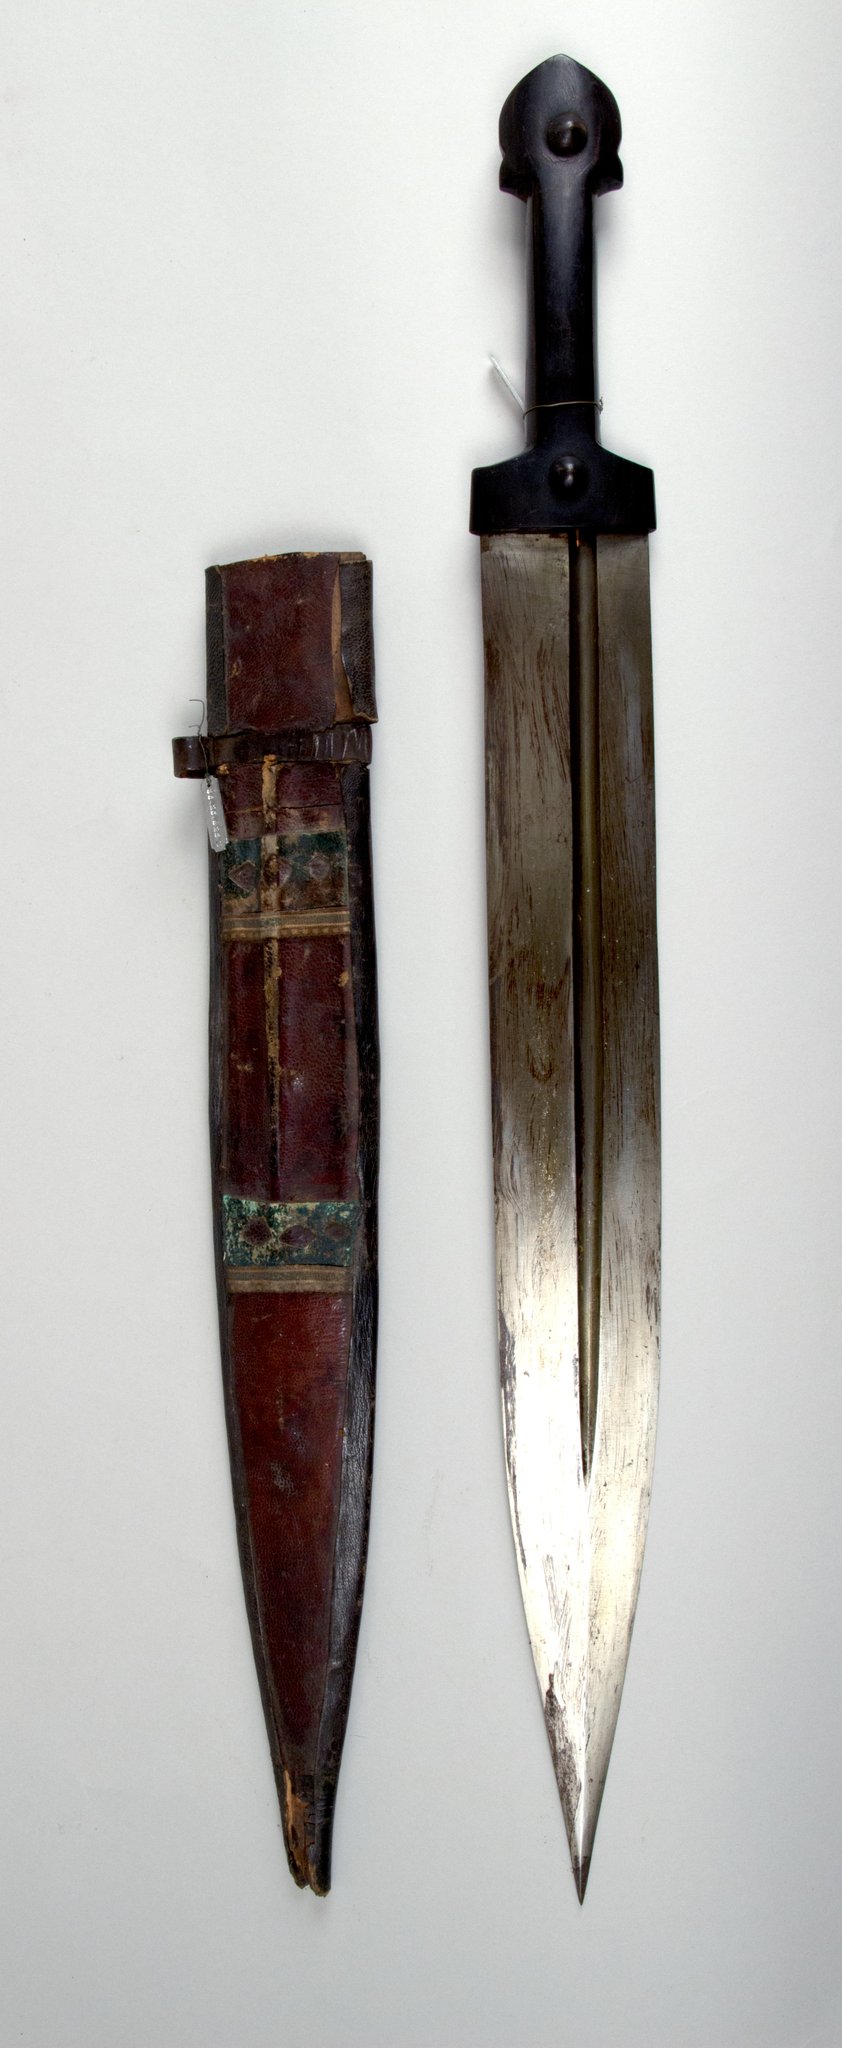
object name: dagger kindjal with sheath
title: Dagger (Kindjal) with Sheath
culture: caucasian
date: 1701-1900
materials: gold, horn, leather, steel, wood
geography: caucasus